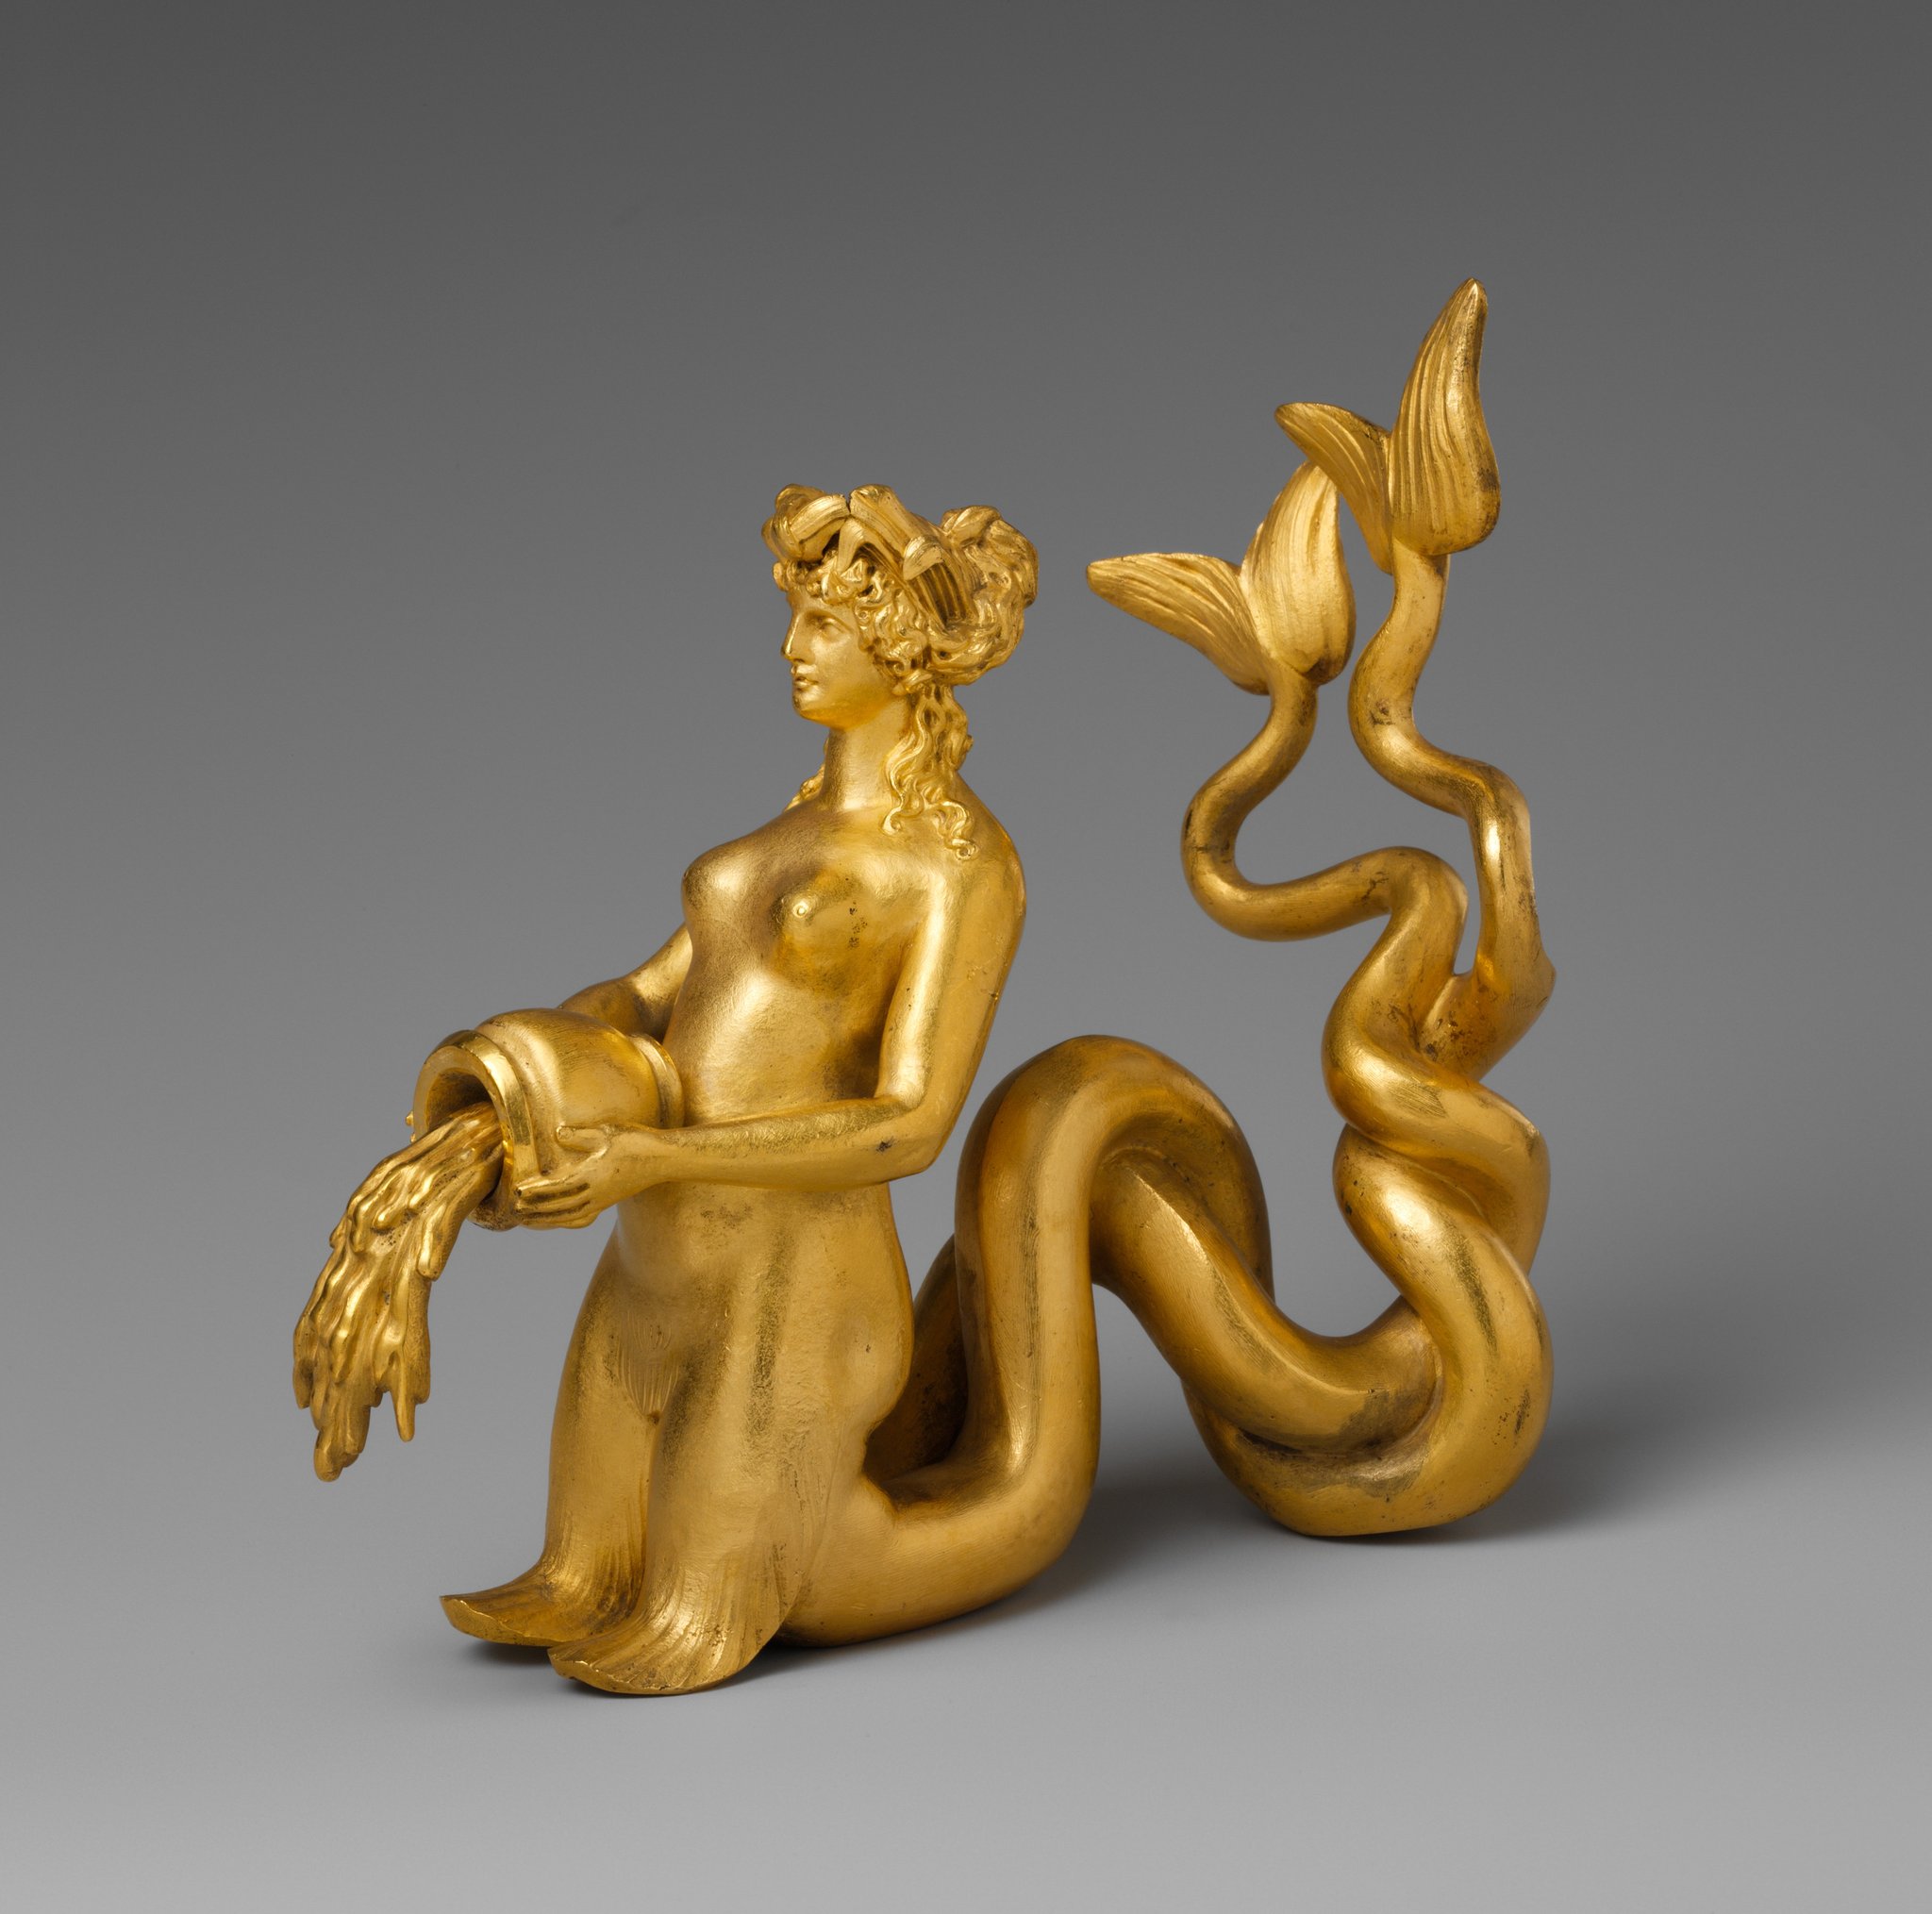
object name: finial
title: Pair of finials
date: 1801-1833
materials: gilt bronze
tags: female nudes